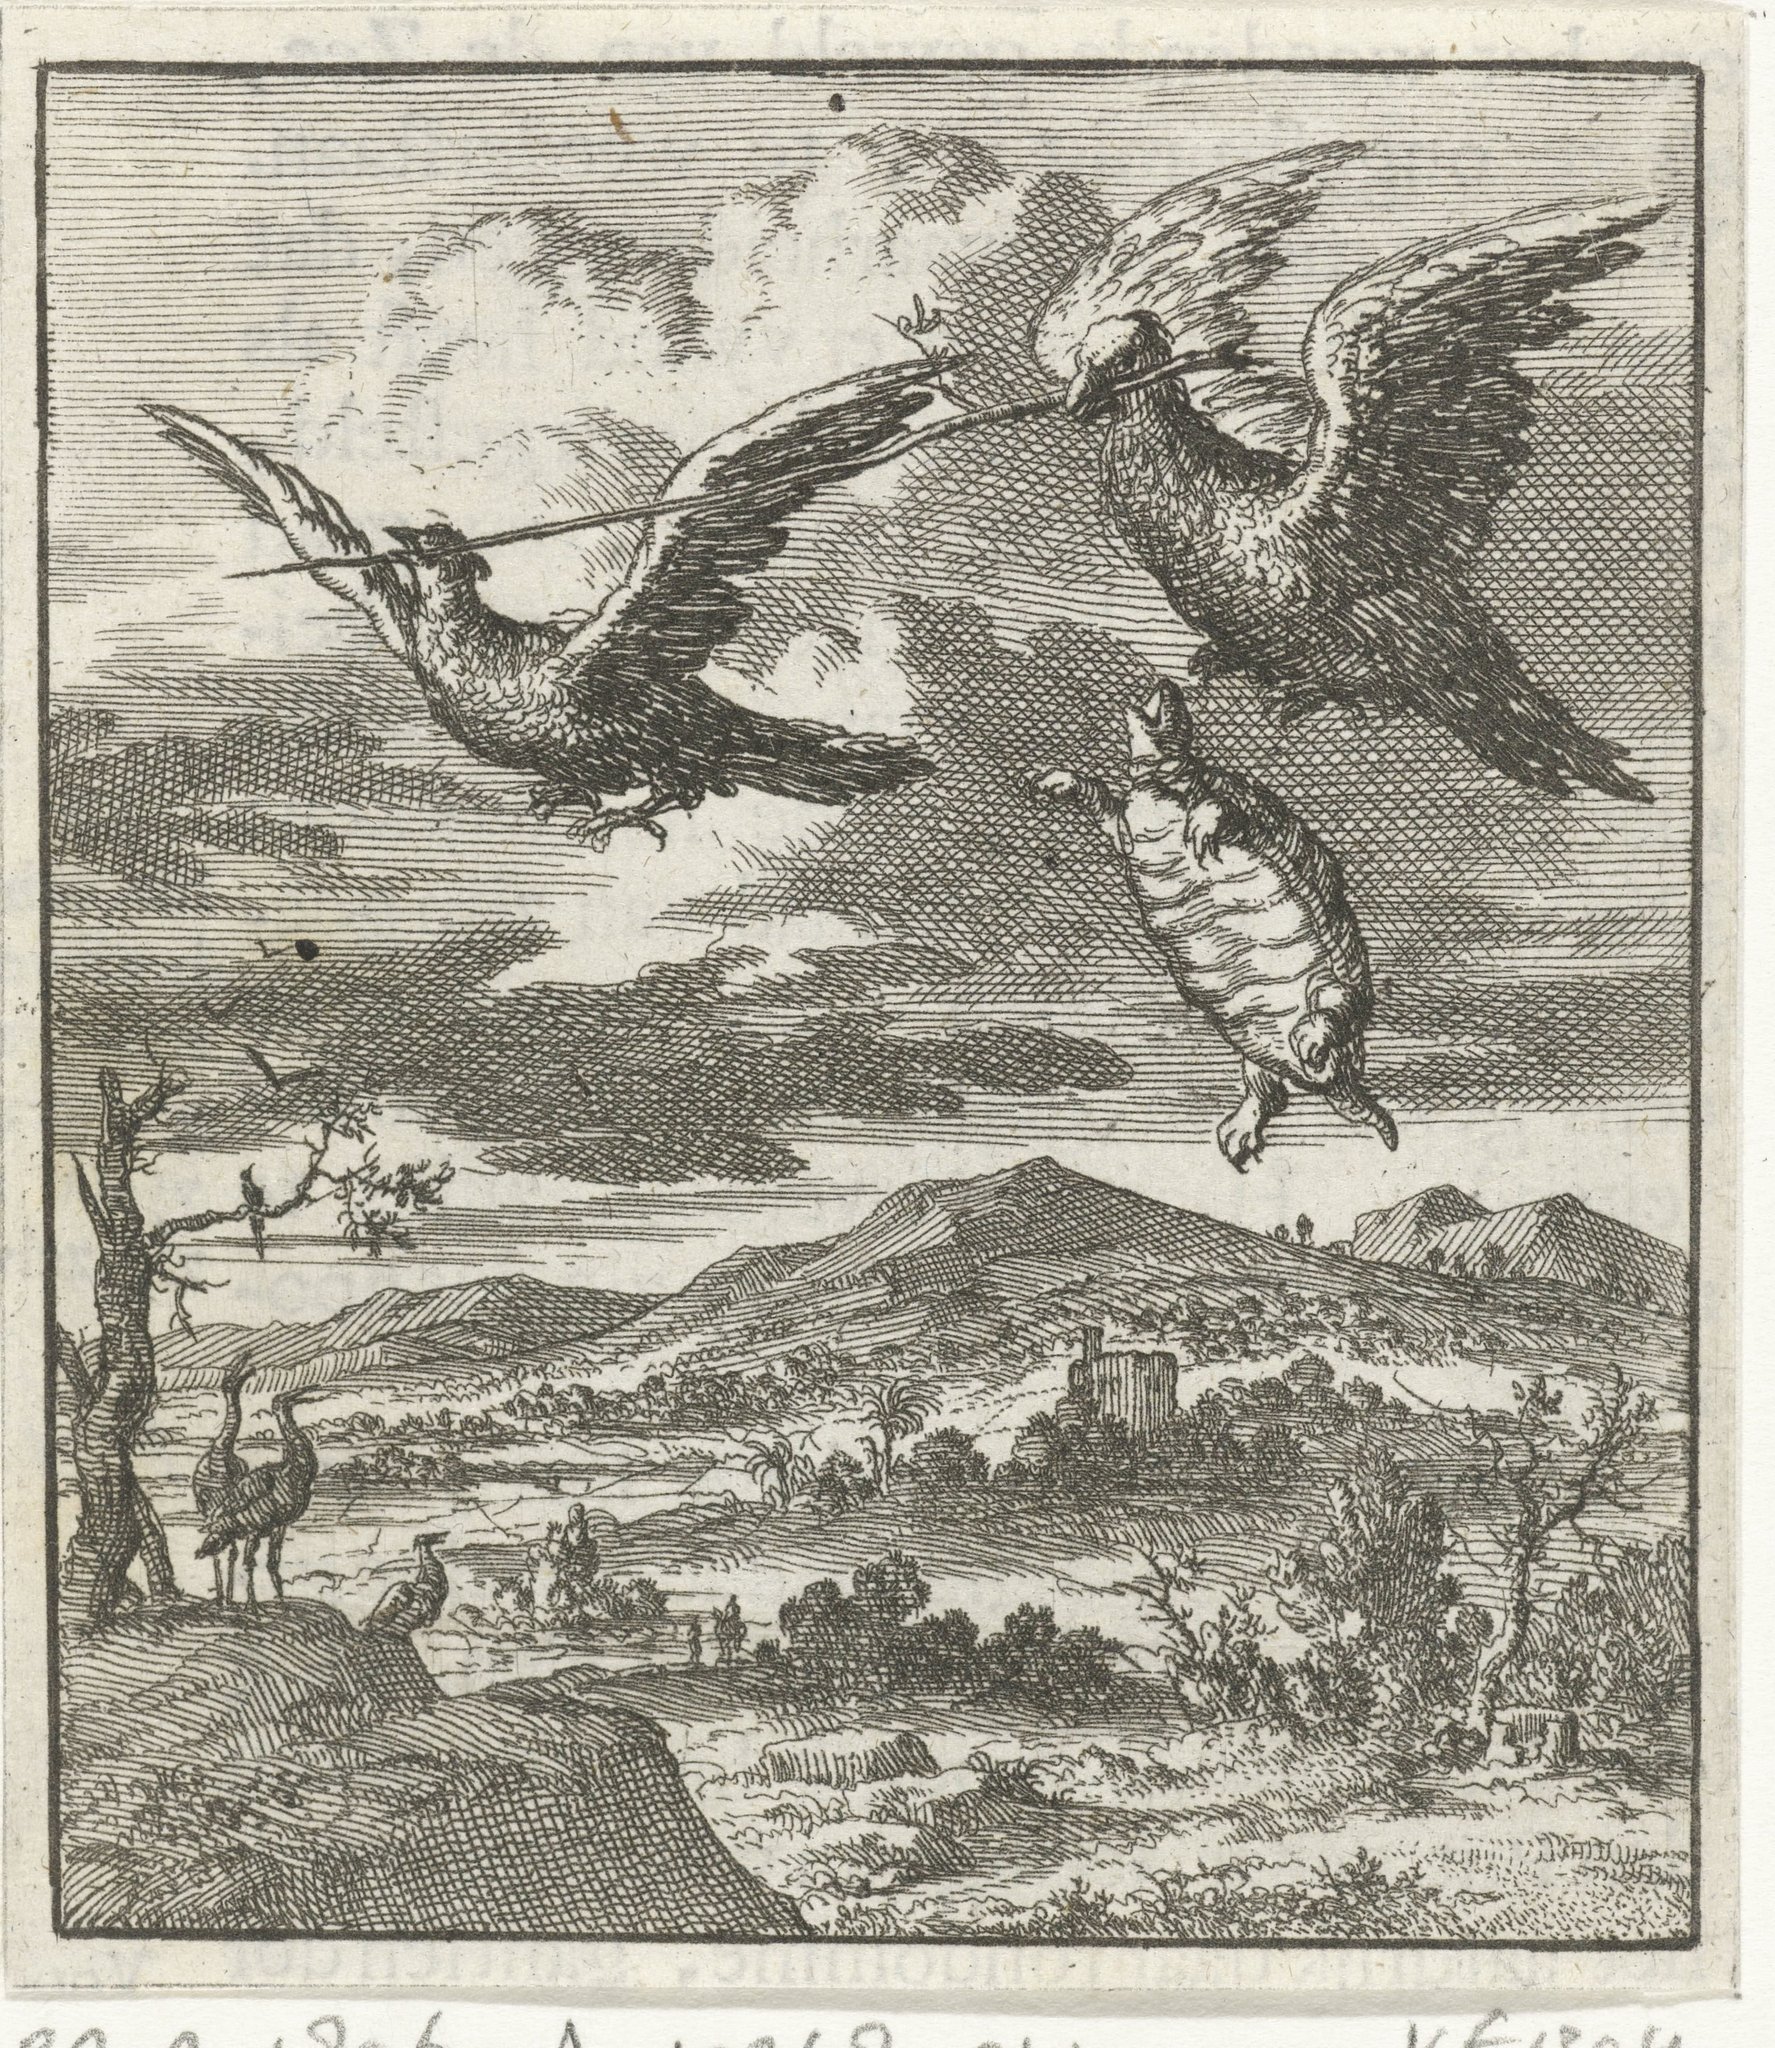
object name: print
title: Twee vogels dragen samen al vliegend een stok waar een schildpad zich aan vasthield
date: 1693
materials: paper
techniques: etching, letterpress printing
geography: amsterdam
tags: flying on or with the aid of animal(s), tortoises, turtles, birds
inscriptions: collector's mark: Lugt 2228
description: Illustratie uit: Duĳkerius, Johannes. Voorbeeldzels der oude wyzen. Waar in (...) de menschelijke hartstogten (...) behandeld worden. Amsterdam: Aart Wolsgrein, 1693, p. 114.